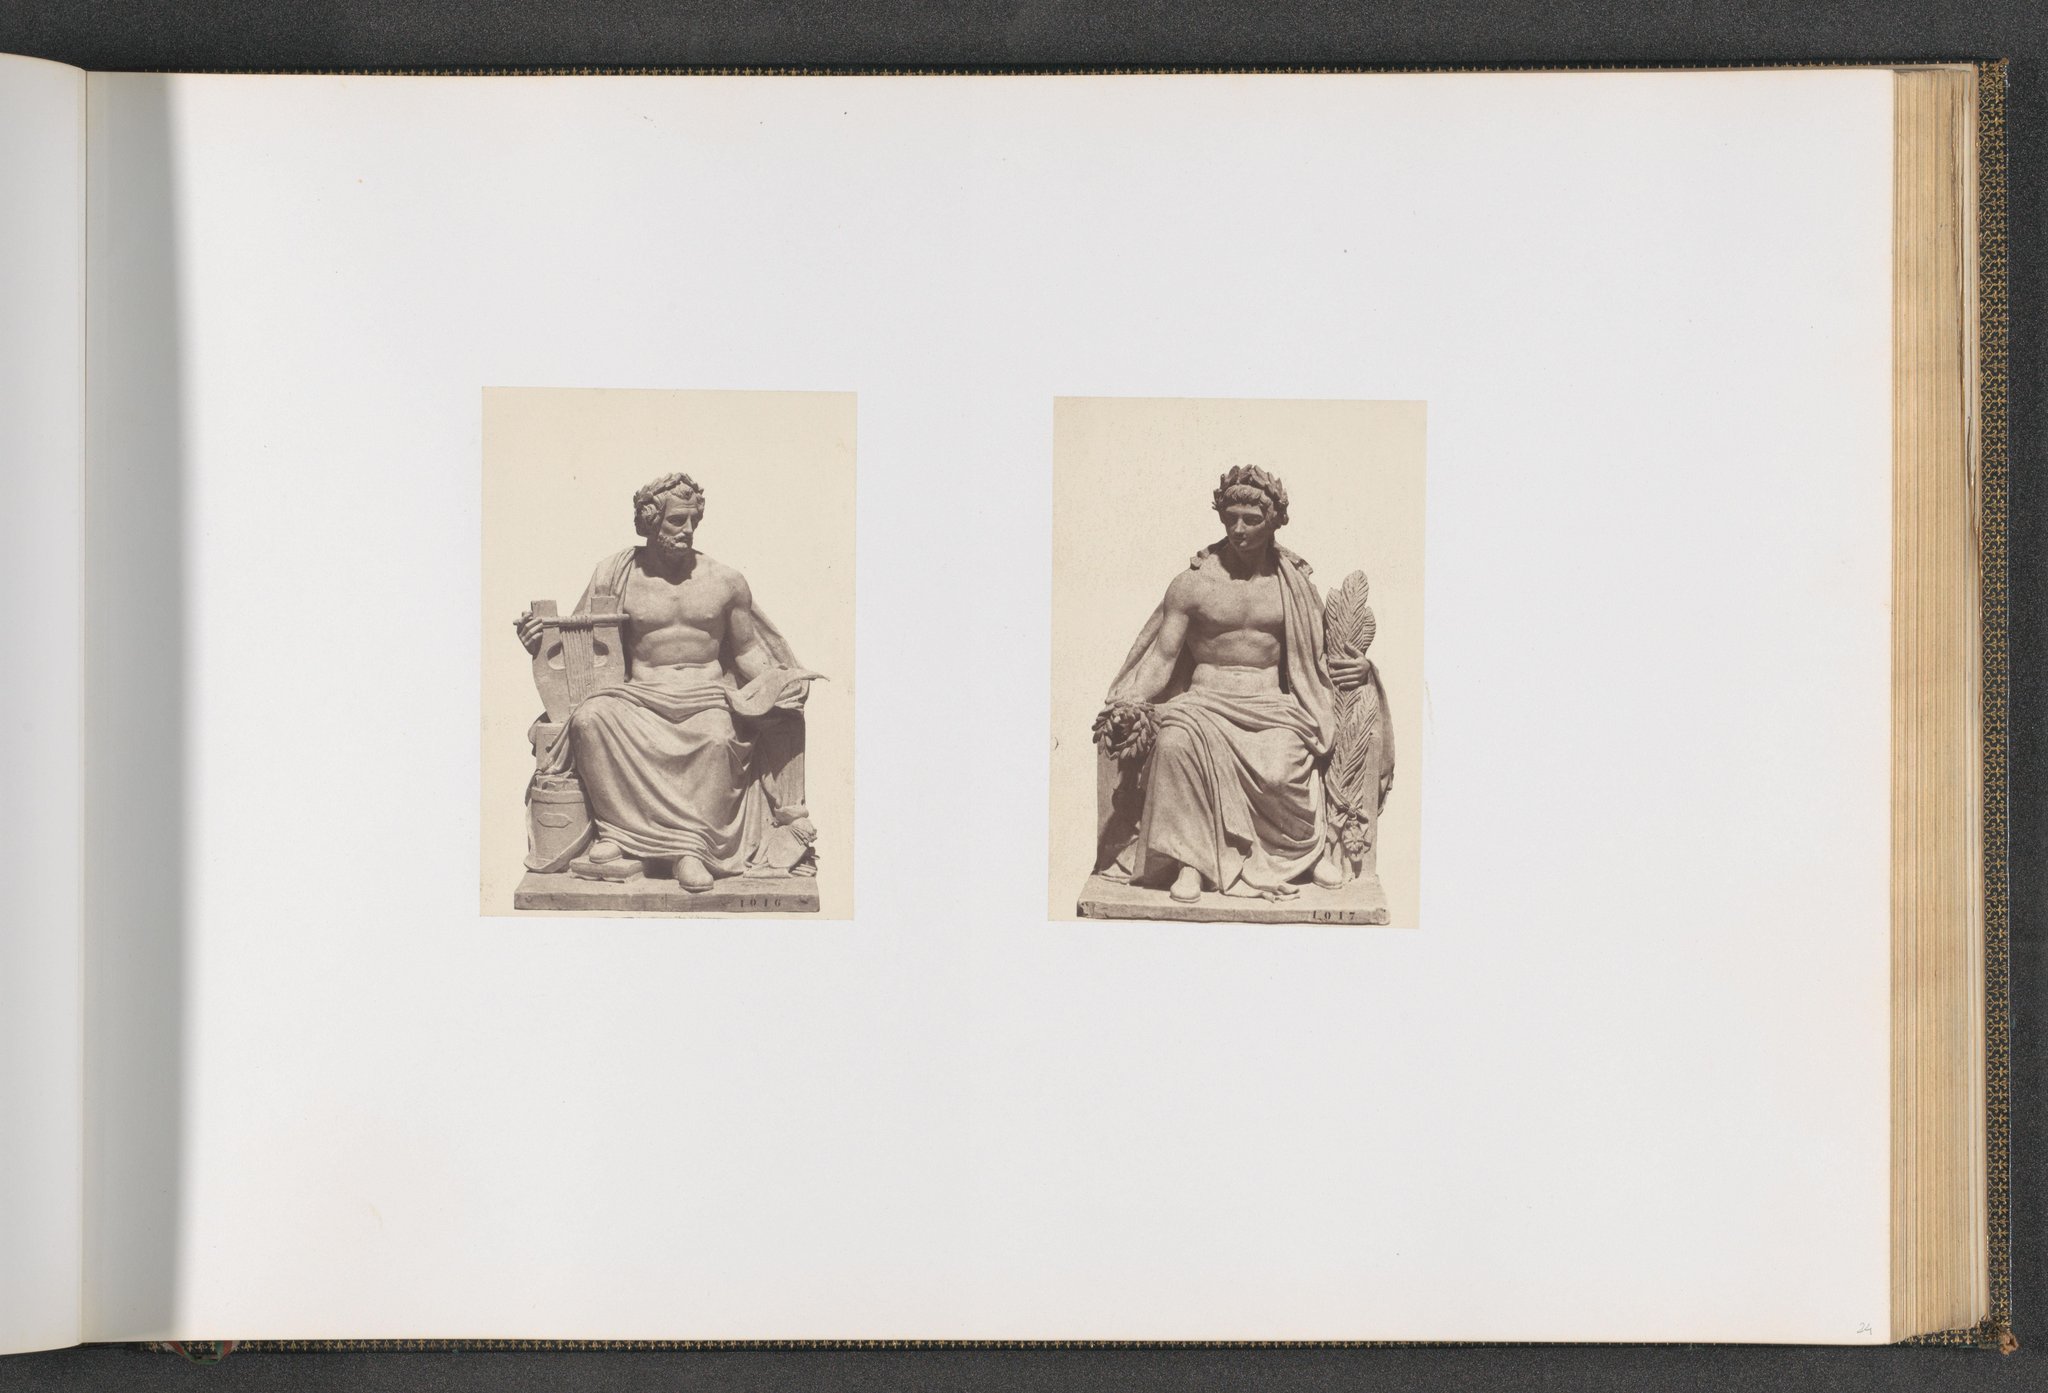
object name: album leaf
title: Gipsmodellen voor beeldhouwwerken op het Palais du Louvre: links "L'Art" en rechts "L'Encouragement" door Nanteuil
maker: édouard denis baldus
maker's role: fotograaf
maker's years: 1813-1889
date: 1855-1857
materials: paper, photographic support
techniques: salted paper print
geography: paris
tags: piece of sculpture, reproduction of a piece of sculpture, permanent exhibition, museum, paris, tuileries palace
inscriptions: number: ‘1016 en 1017’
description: Onderdeel van Réunion des Tuileries au Louvre 1852-1857, album 2.